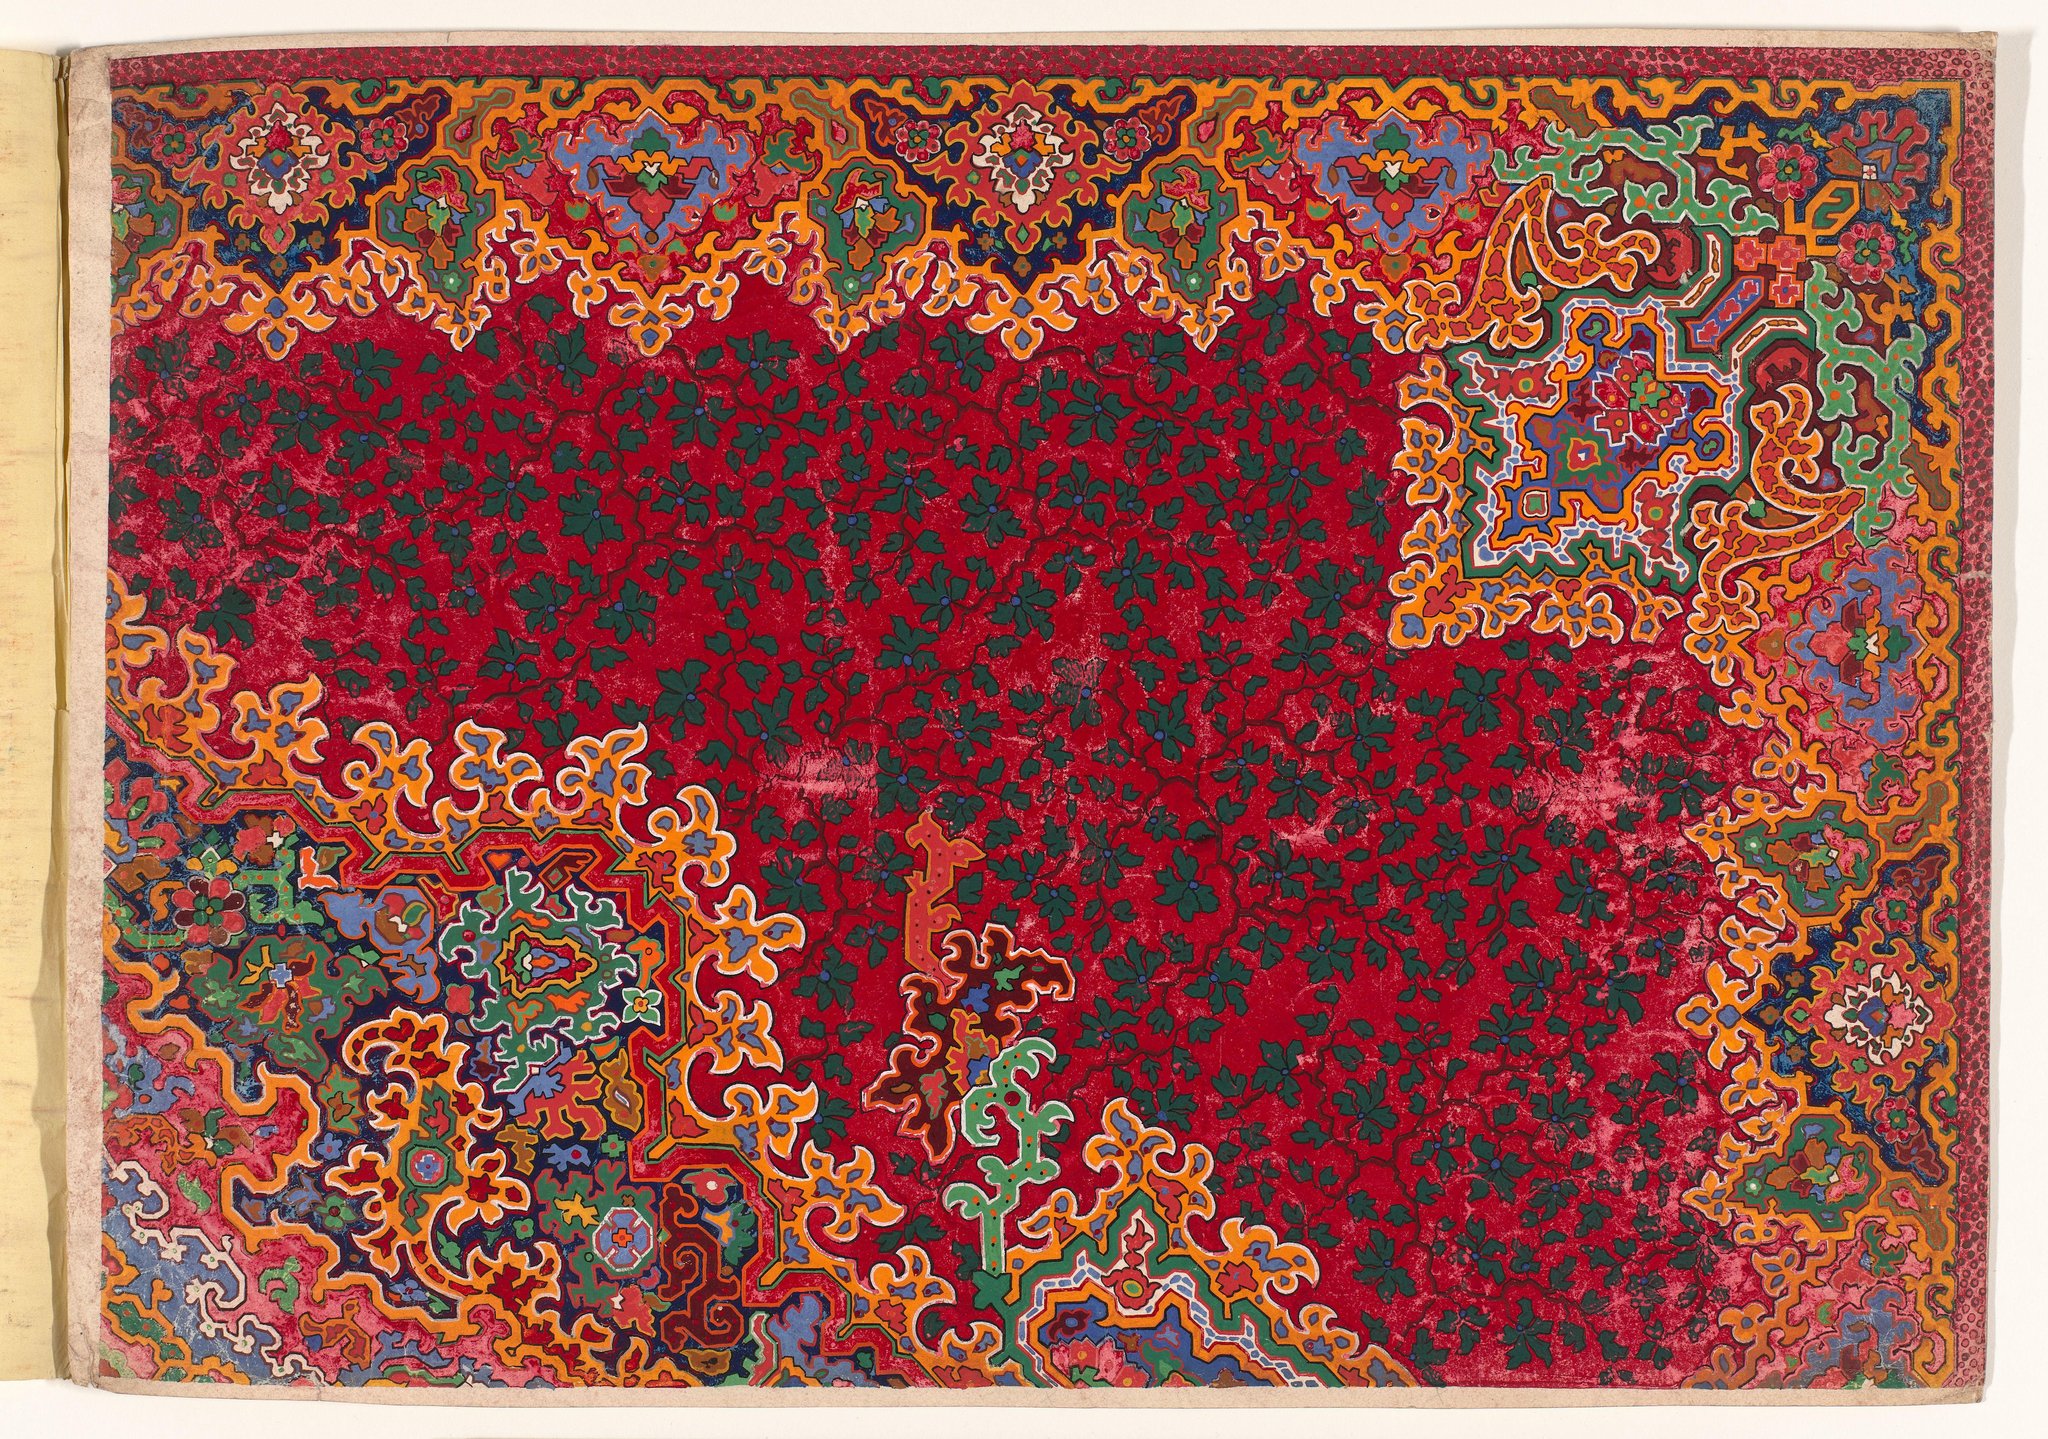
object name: design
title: Ontwerp voor een tapijt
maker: Anonymous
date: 1854-1864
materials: gouache, paper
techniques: brush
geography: amsterdam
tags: ornaments ~ art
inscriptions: inscription: ‘552. Ned, dm is de smalste breedte waar in deze in 1sten kwaliteit kan uitgevoerd worden’, retailer's mark: ‘JHS.’, number: ‘No 362’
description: De presentatietekeningen BK-1971-77-1 t/m 86 zijn kopieën van de originele ontwerptekeningen. Ze werden gemaakt voor vertegenwoordigers van bijvoorbeeld magazijnen, die ze aan hun klanten konden tonen. De meeste tekeningen tonen een kwart van het dessin inclusief rand, middenpartij (de zogenaamde grond of fond) en centraal medaillon. Door het gebruik van spiegels kan de illusie van het gehele tapijt worden opgeroepen. Een deel van de tekeningen heeft een alfabetische opeenvolgende letter als kenmerk, de andere groep een cijfer.Waarschijnlijk is de reeks dessins met een letter eerder samengesteld dan de genummerde tekeningen.